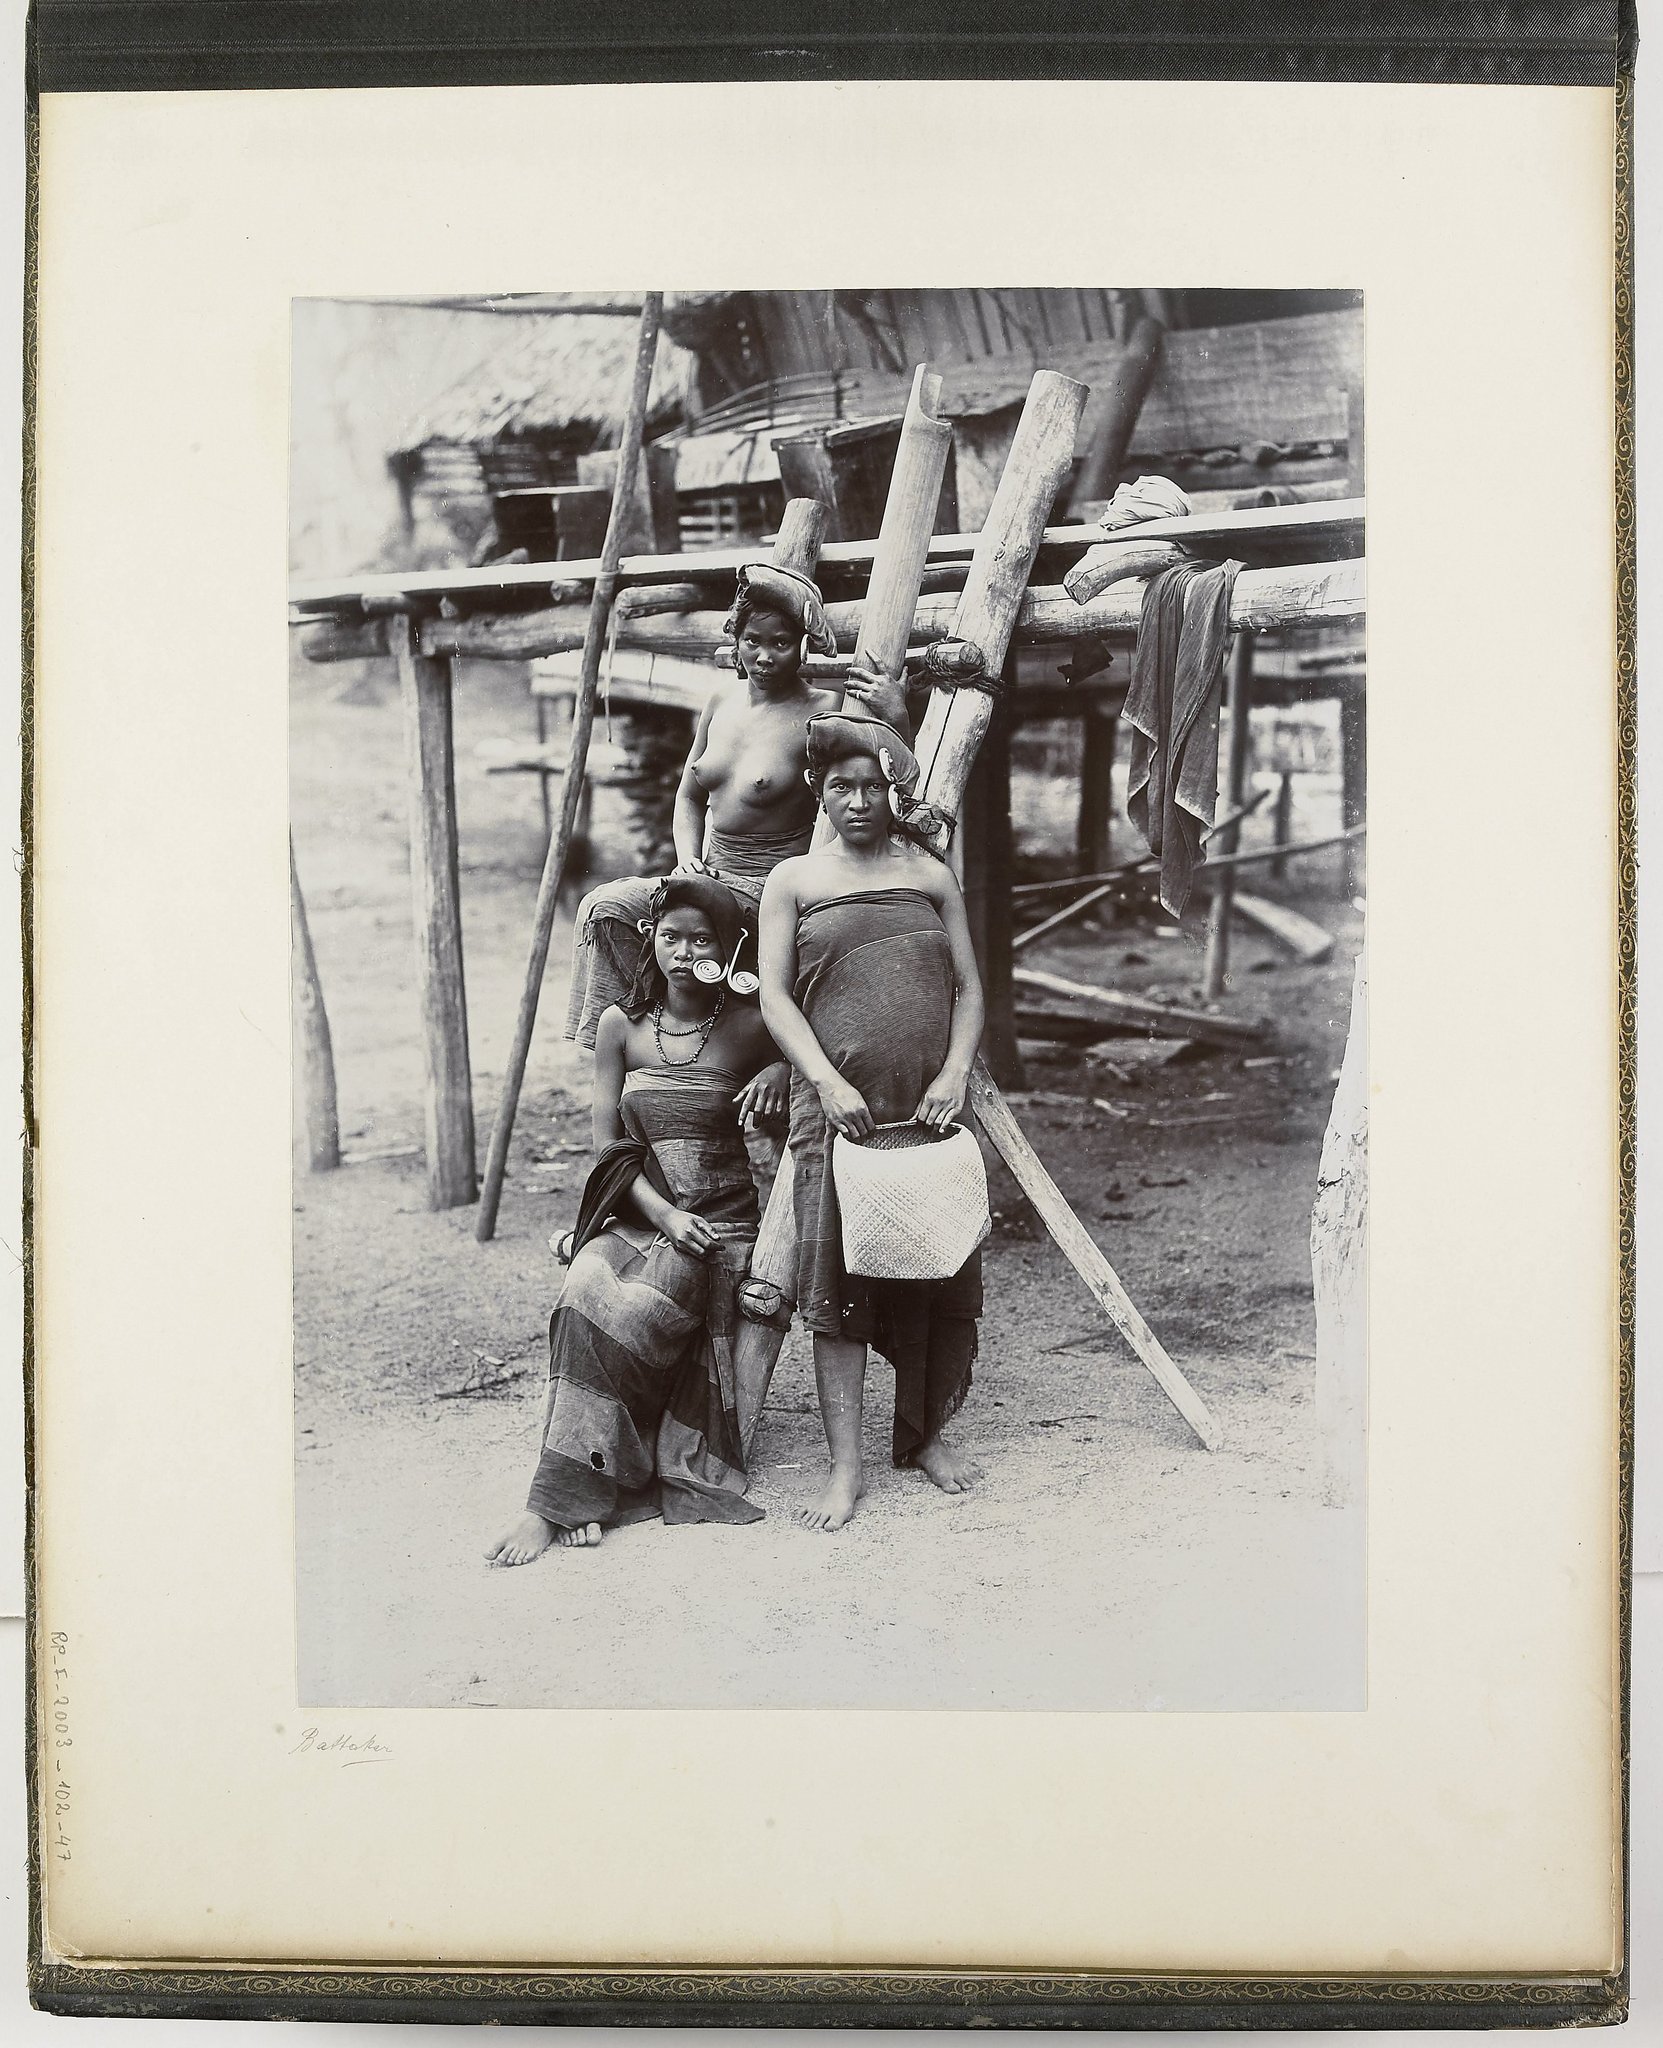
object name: photograph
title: Groepsportret van Batakse vrouwen met werktuigen voor het rijst stampen, Sumatra (Battak-Frauen, Reis stampfend)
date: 1890-1895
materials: photographic support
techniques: collodion silver print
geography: medan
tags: sumatra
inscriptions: inscription: ‘Battaker’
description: Groepsportret van drie jonge Batak vrouwen met werktuigen voor het stampen van rijst, in een Batakdorp op Sumatra. Onderdeel van het Sumatra fotoalbum van Paul en Lucie Sandel uit 1900.